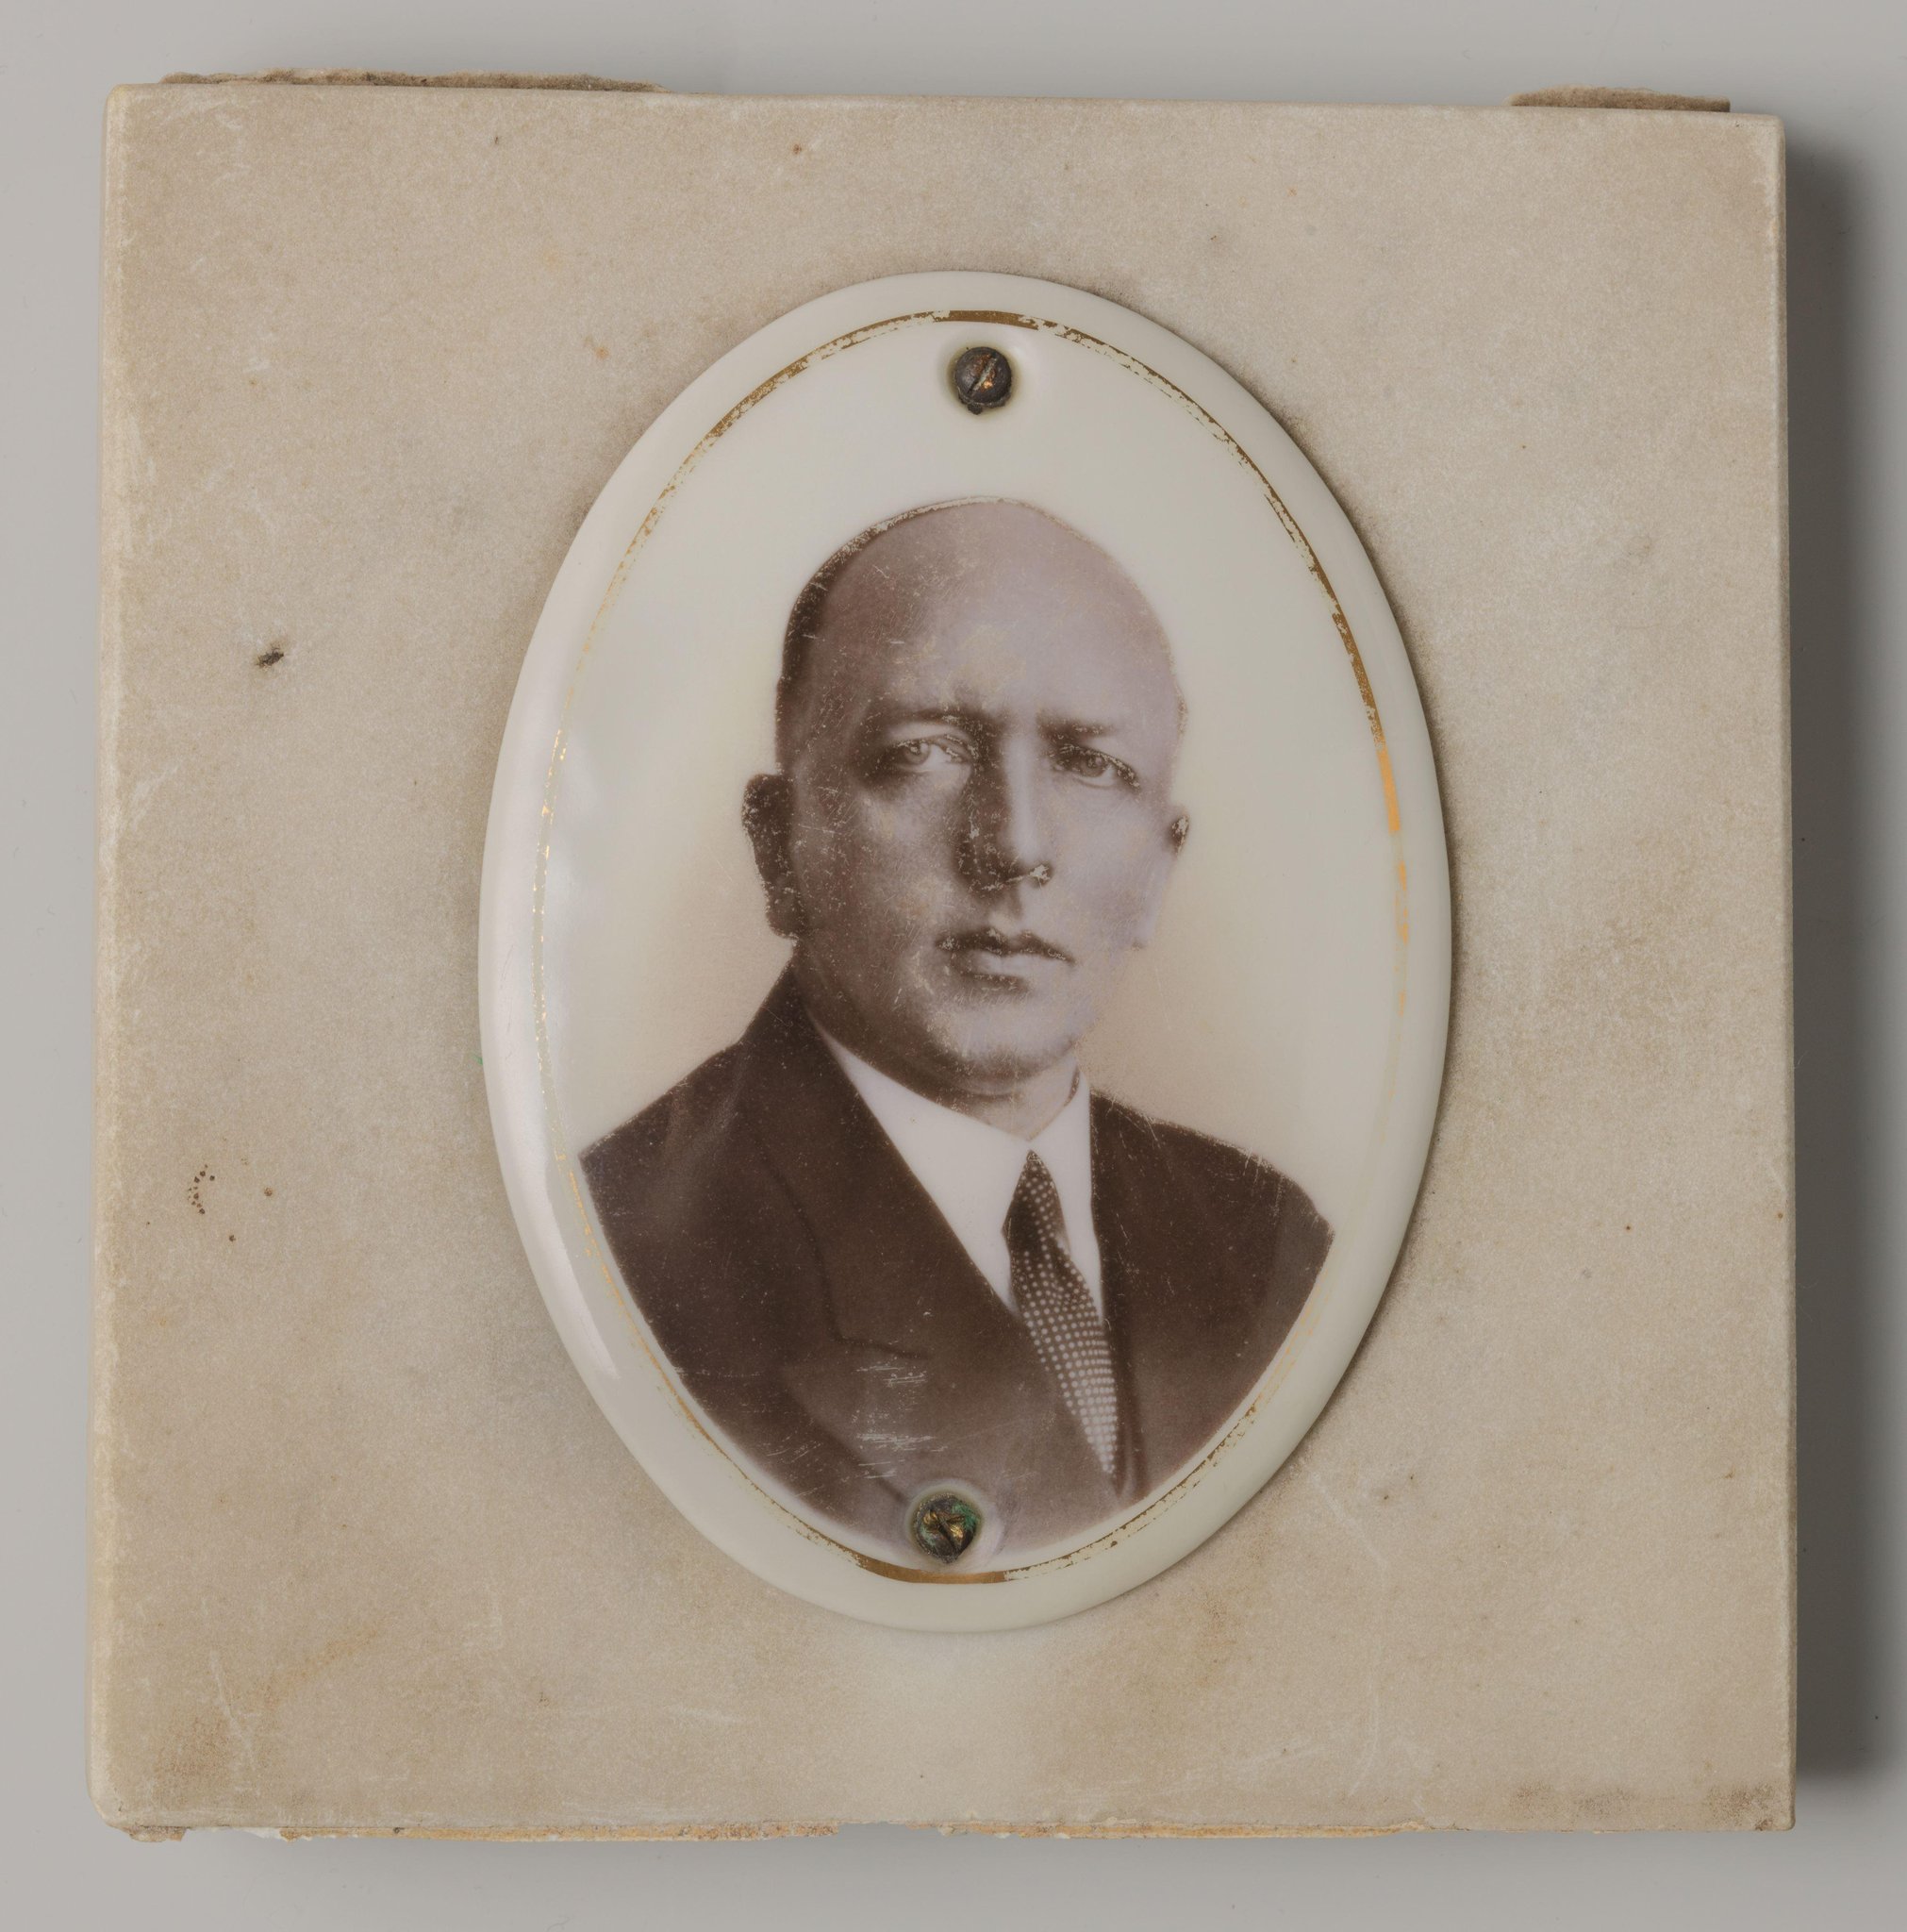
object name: photograph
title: Grafportret van een onbekende man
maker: Anonymous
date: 1910-1950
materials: ceramic, glass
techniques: photoceramics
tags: adult man